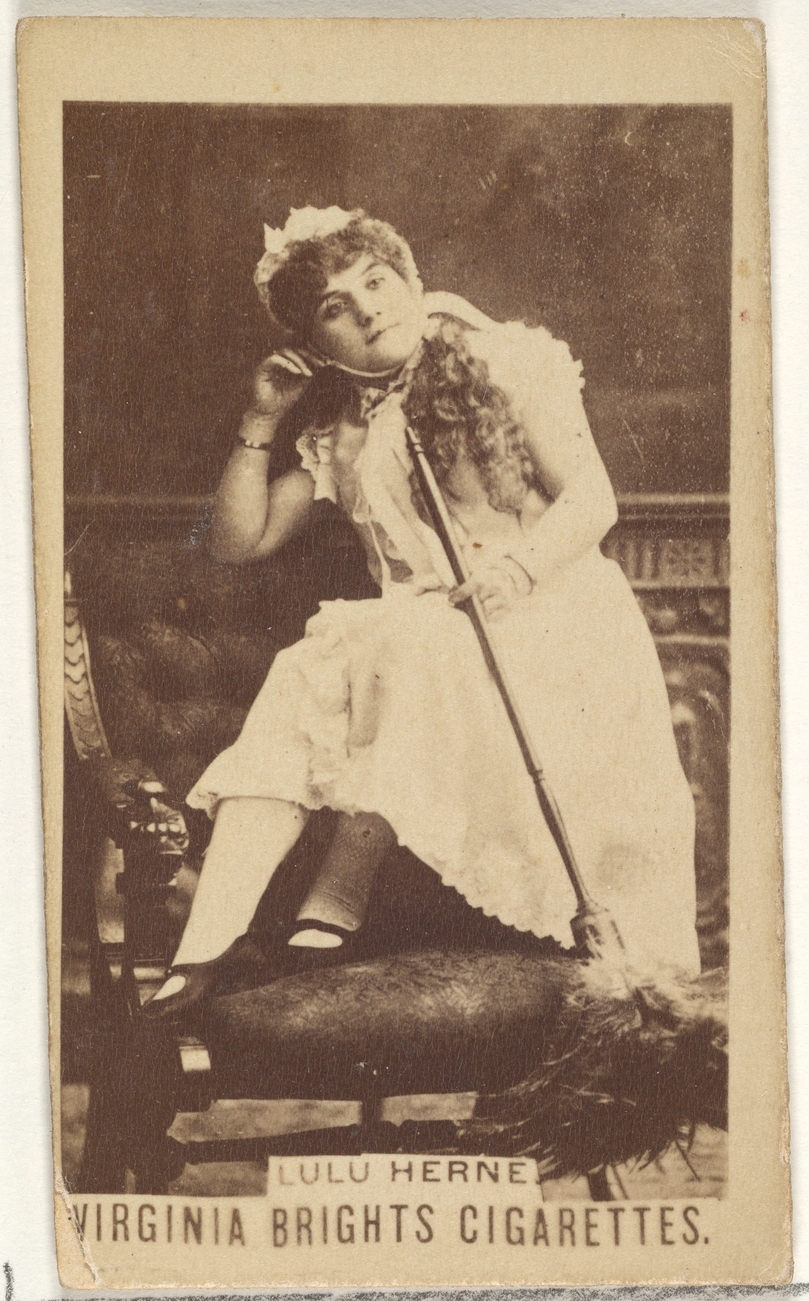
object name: photograph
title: Lulu Herne, from the Actors and Actresses series (N45, Type 1) for Virginia Brights Cigarettes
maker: allen & ginter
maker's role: publisher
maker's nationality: american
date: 1888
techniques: albumen silver print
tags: portraits,women,actresses